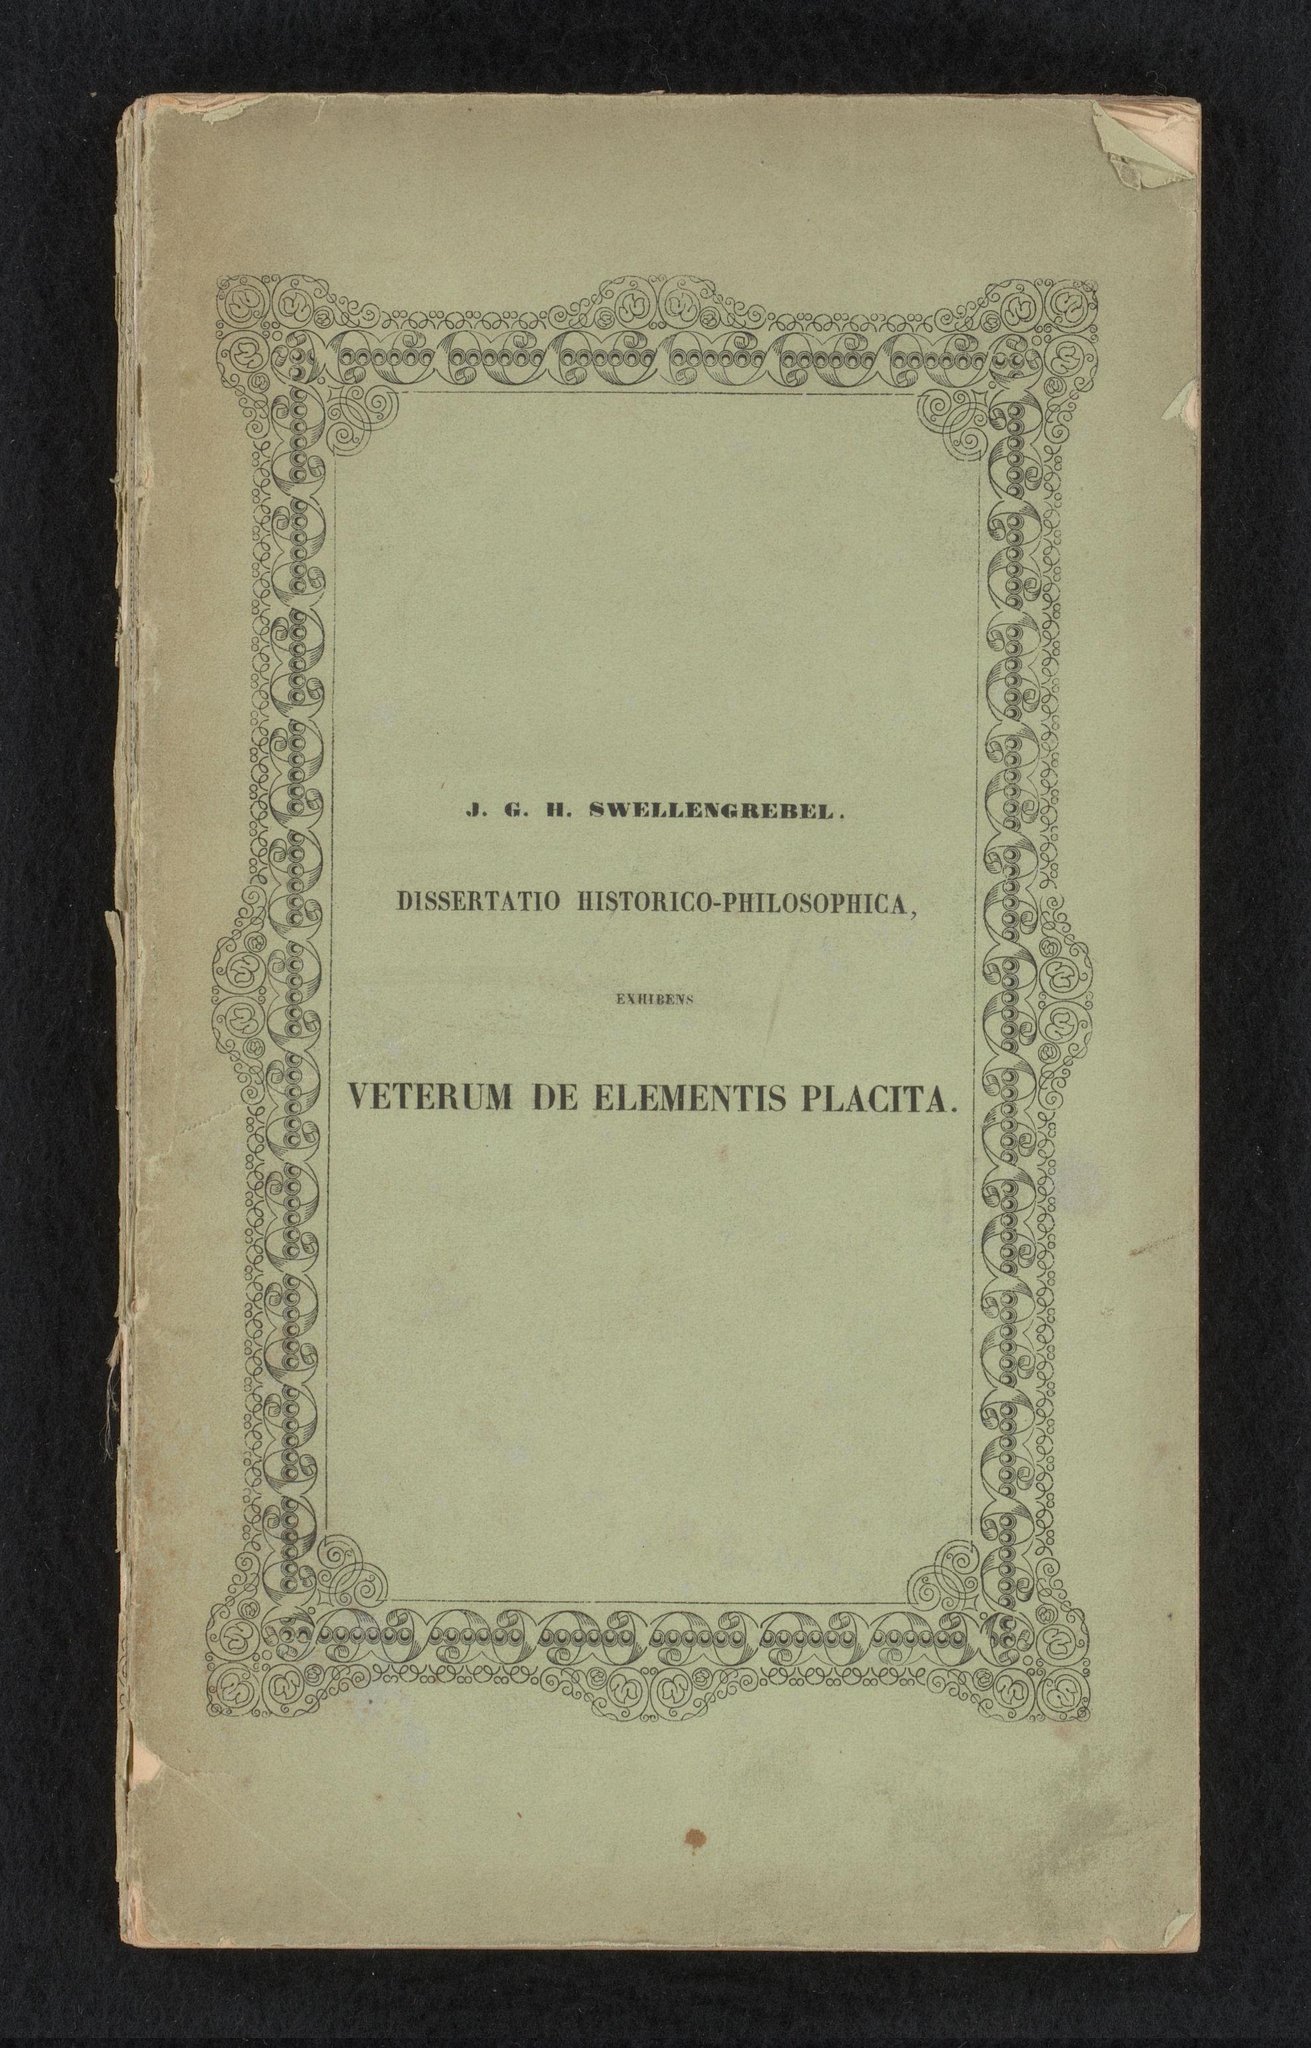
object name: book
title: Proefschrift van Johan Gerard Hendrik Swellengrebel, Universiteit Utrecht 1844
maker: johan gerard hendrik swellengrebel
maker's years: 1821-1854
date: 1844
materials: paper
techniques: letterpress printing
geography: netherlands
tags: utrecht, johan gerard hendrik swellengrebel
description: Dissertatio Historico-Philosophica exhibens Veterum de Elementis-Placita. Proefschrift van Joannes Gerardus Henricus Swellengrebel, Universiteit Utrecht 1844. Met omslag van groen papier. Onderdeel van de groep publicaties door leden van het geslacht Swellengrebel.